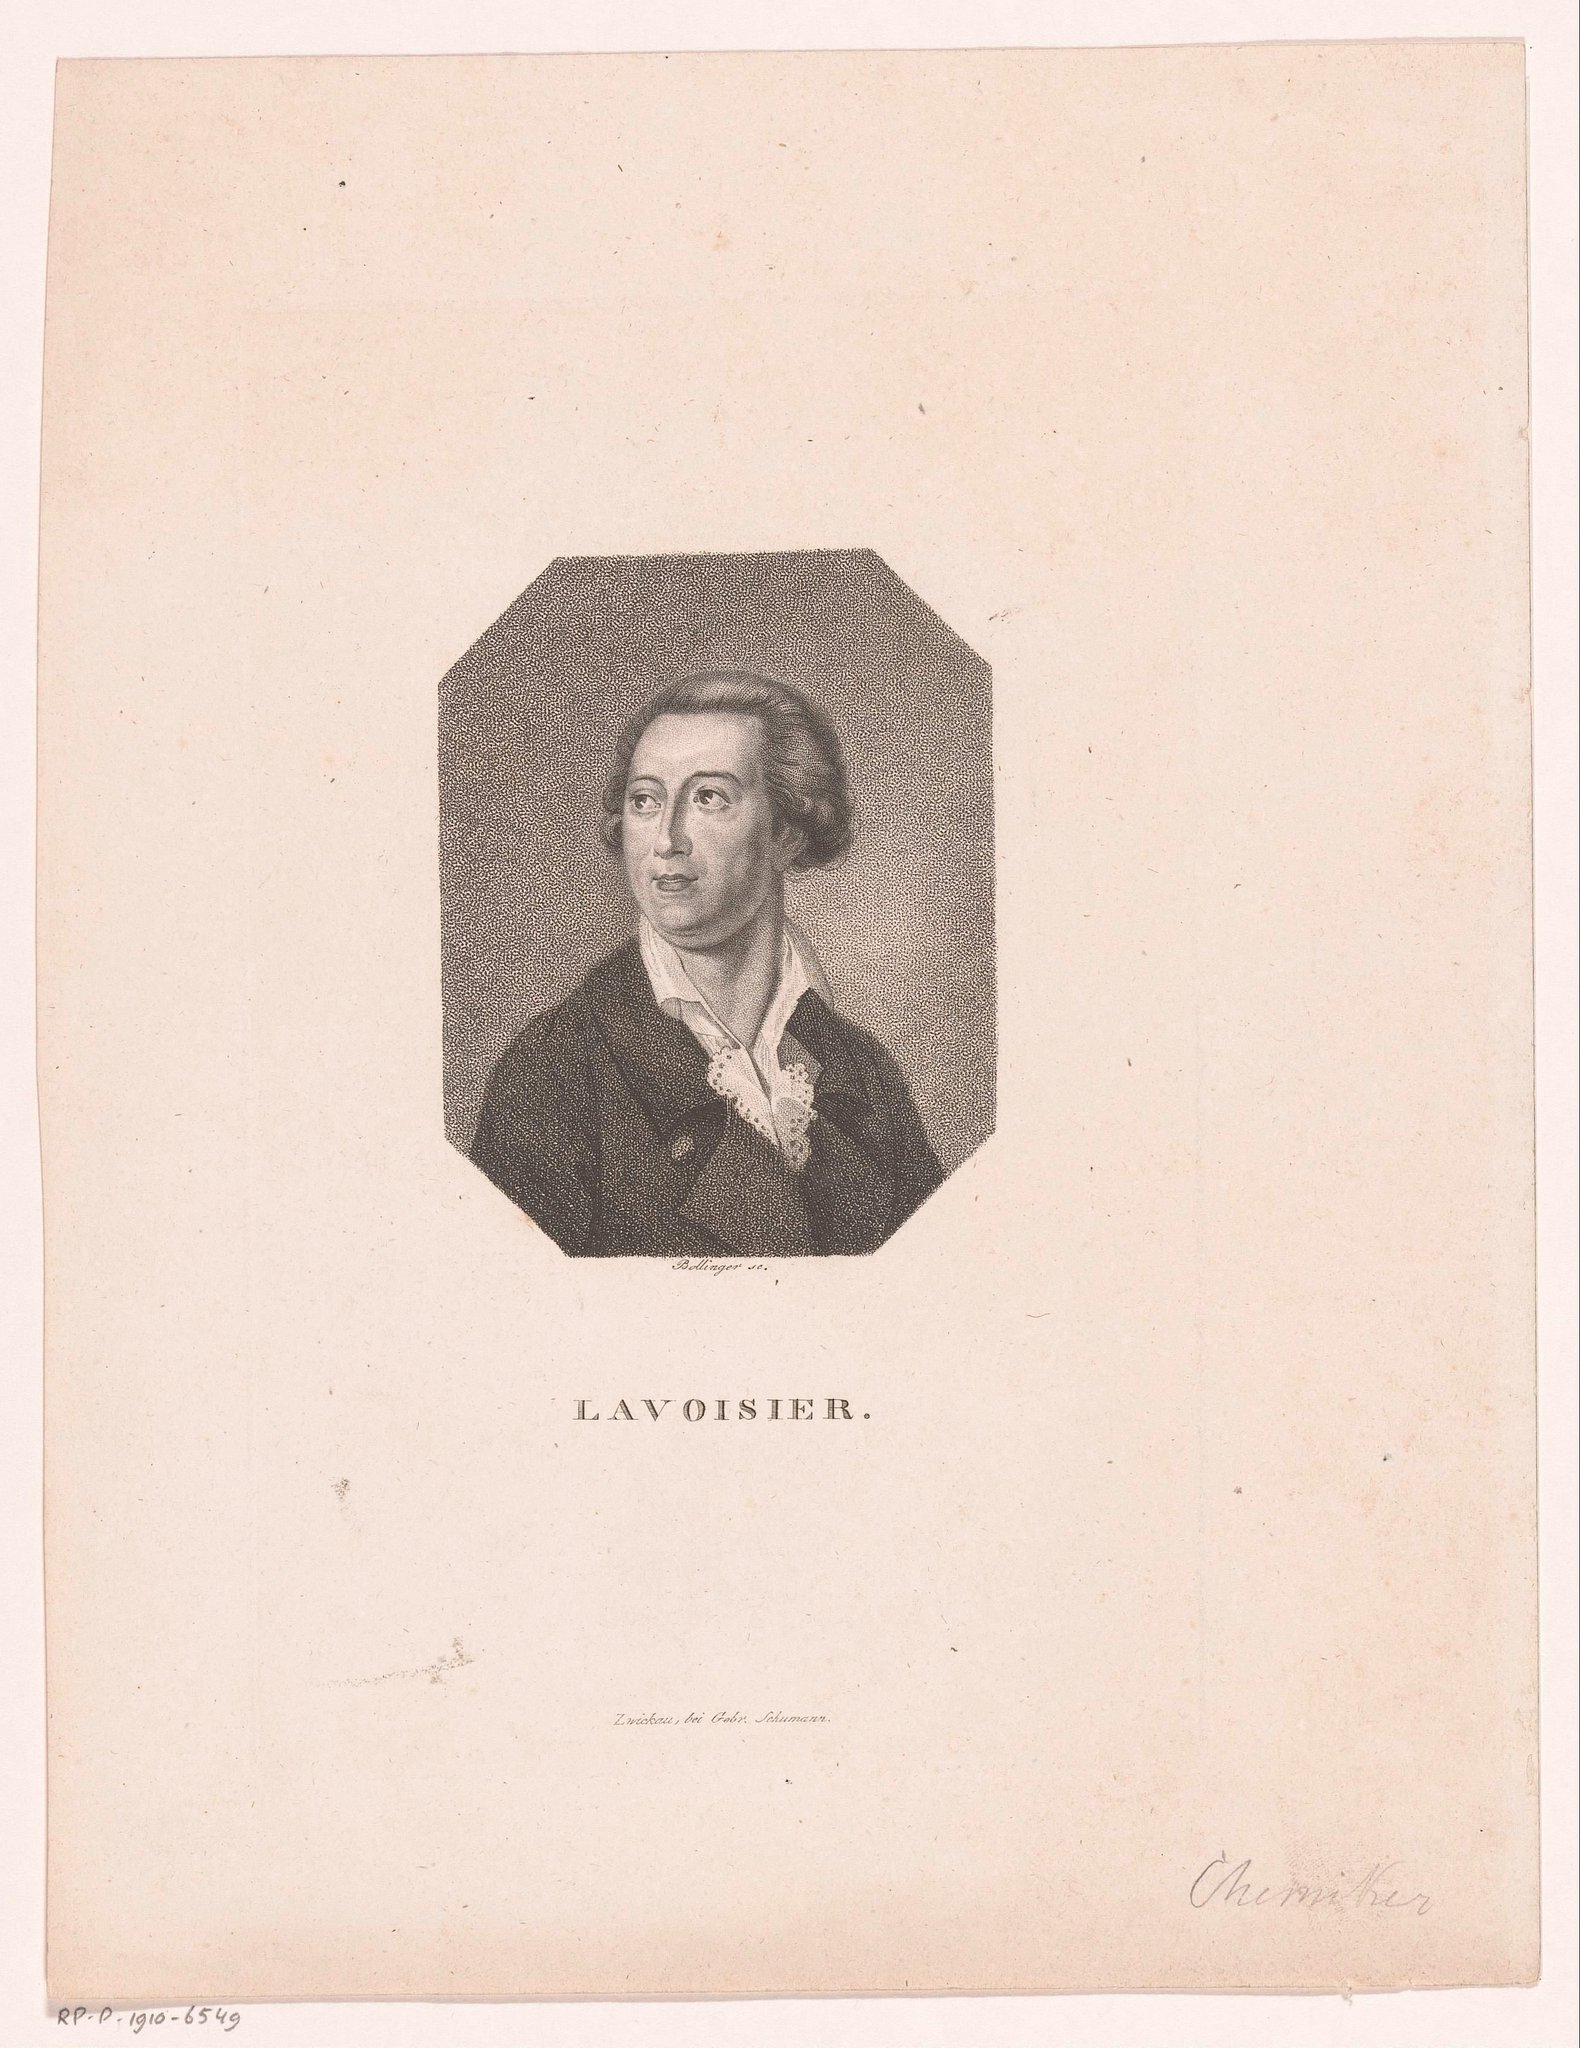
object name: print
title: Portretten van beroemde mensen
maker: friedrich wilhelm bollinger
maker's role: print maker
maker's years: 1777-1825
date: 1818-1832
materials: paper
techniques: stippling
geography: zwickau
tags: paris, historical persons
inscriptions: collector's mark: Lugt 2228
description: Prent gebruikt door de serie 'Bildnisse der berühmtesten Menschen aller Völker und Zeiten' van de gebroeders Schumann, uitgegeven in 1818-1832 te Zwickau.